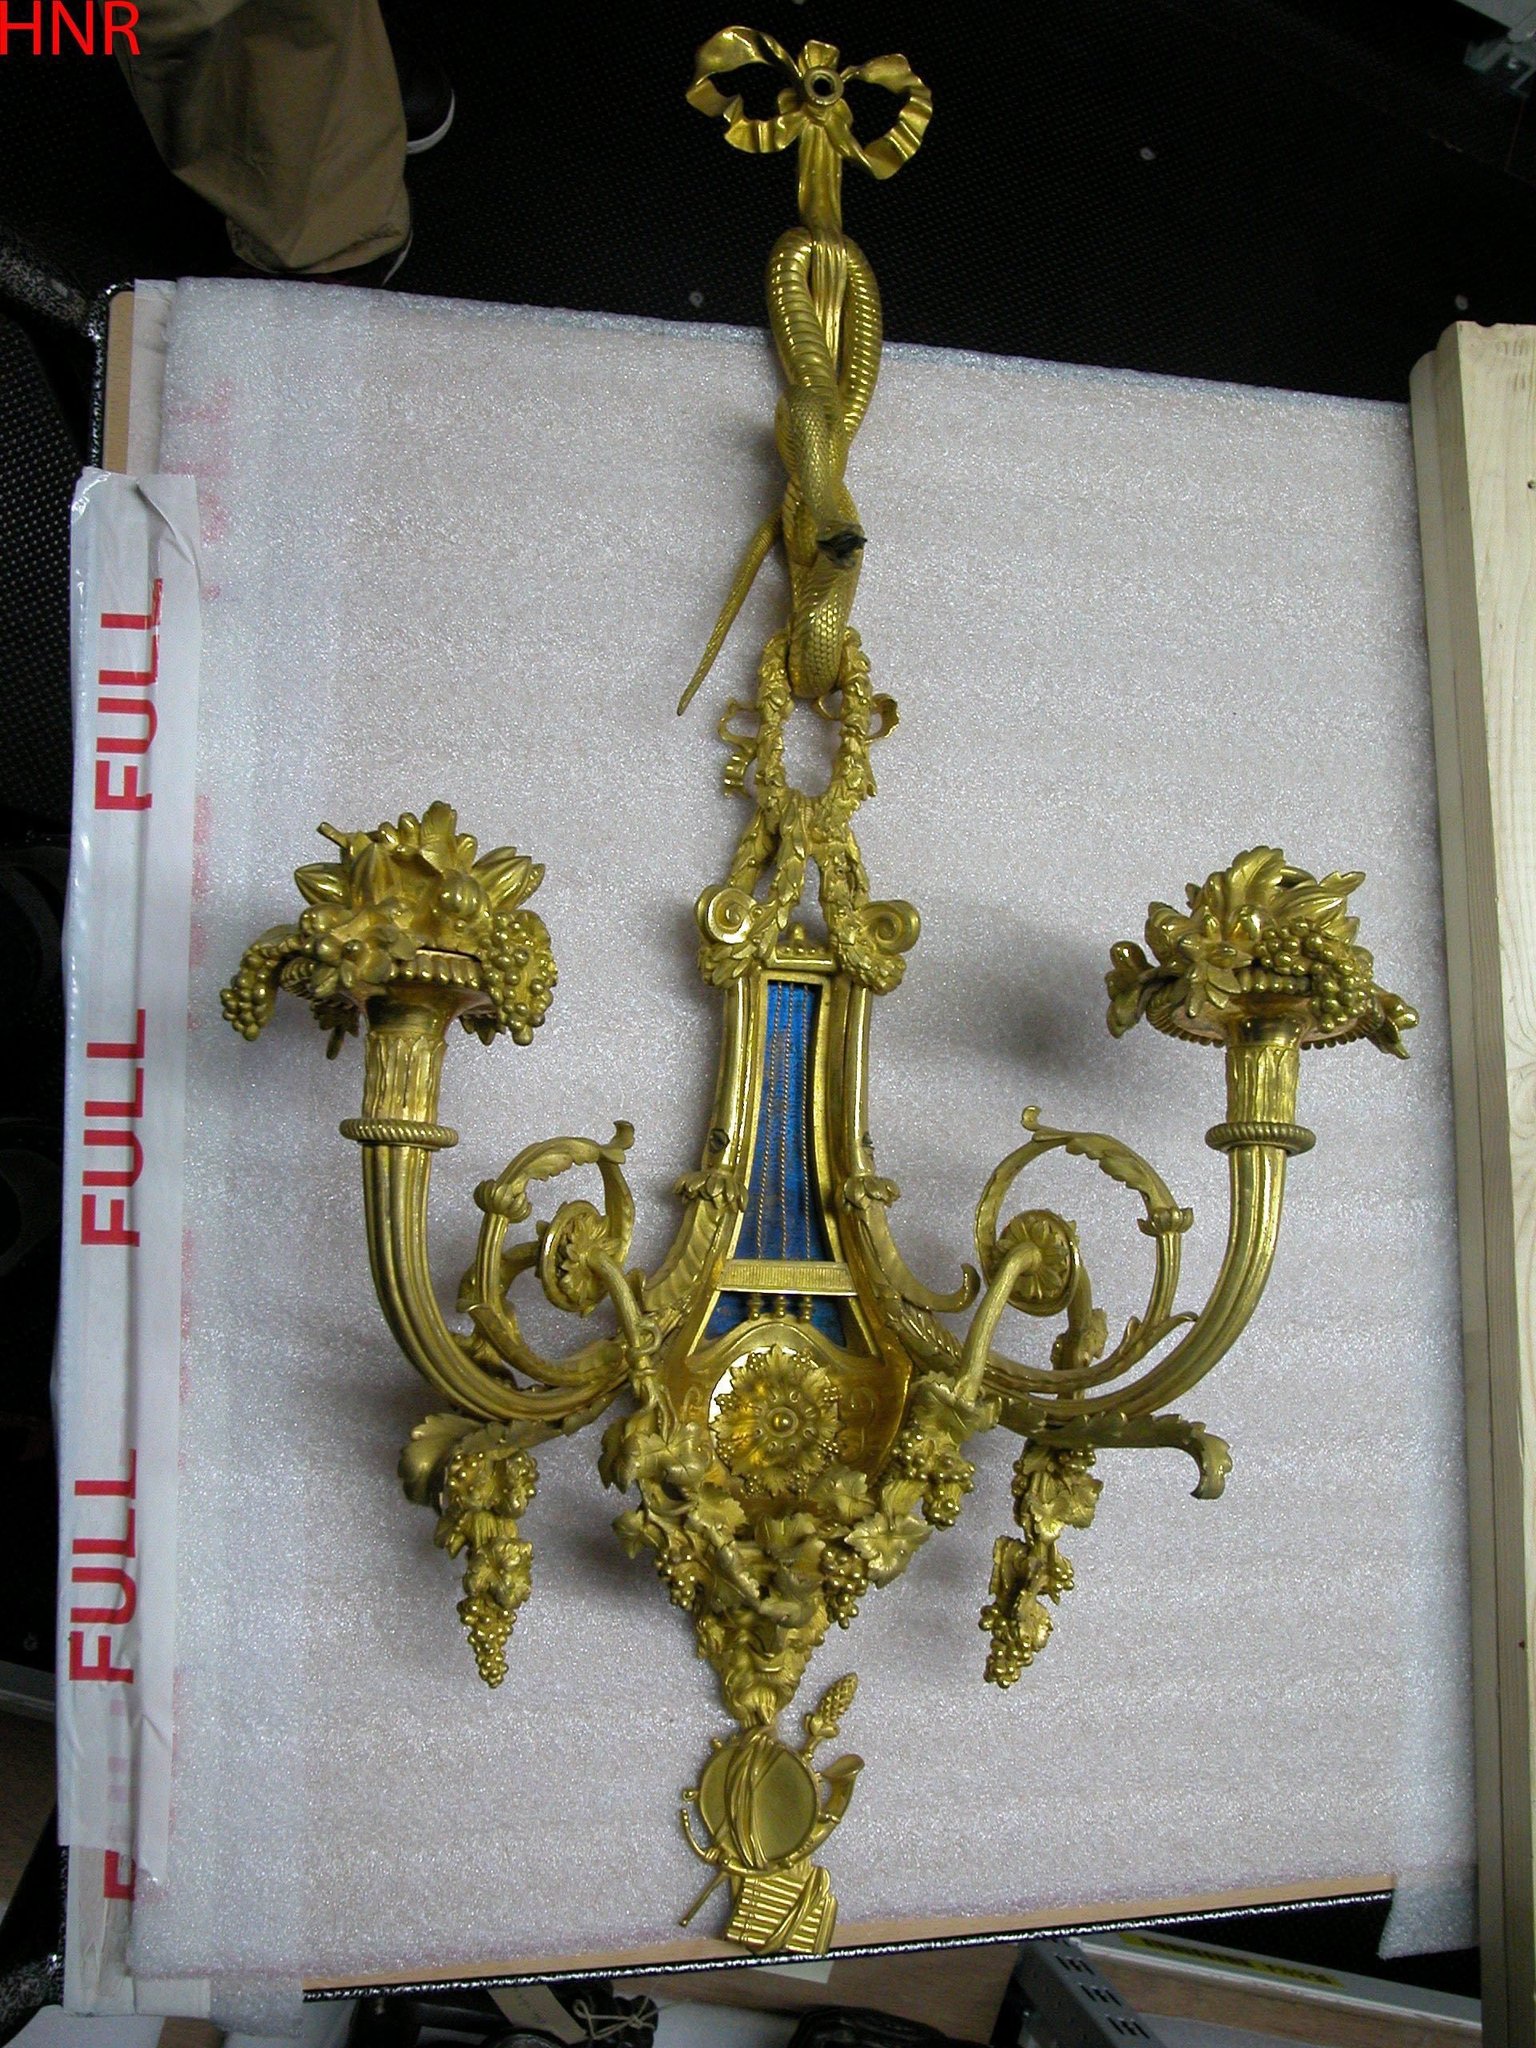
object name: sconce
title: Wandarm van verguld brons met twee armen en liervormige stam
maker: Anonymous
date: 1775-1800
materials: bronze, iron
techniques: gilding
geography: france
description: Two wall-lights. Gilt bronze. Paris, c. 1780.